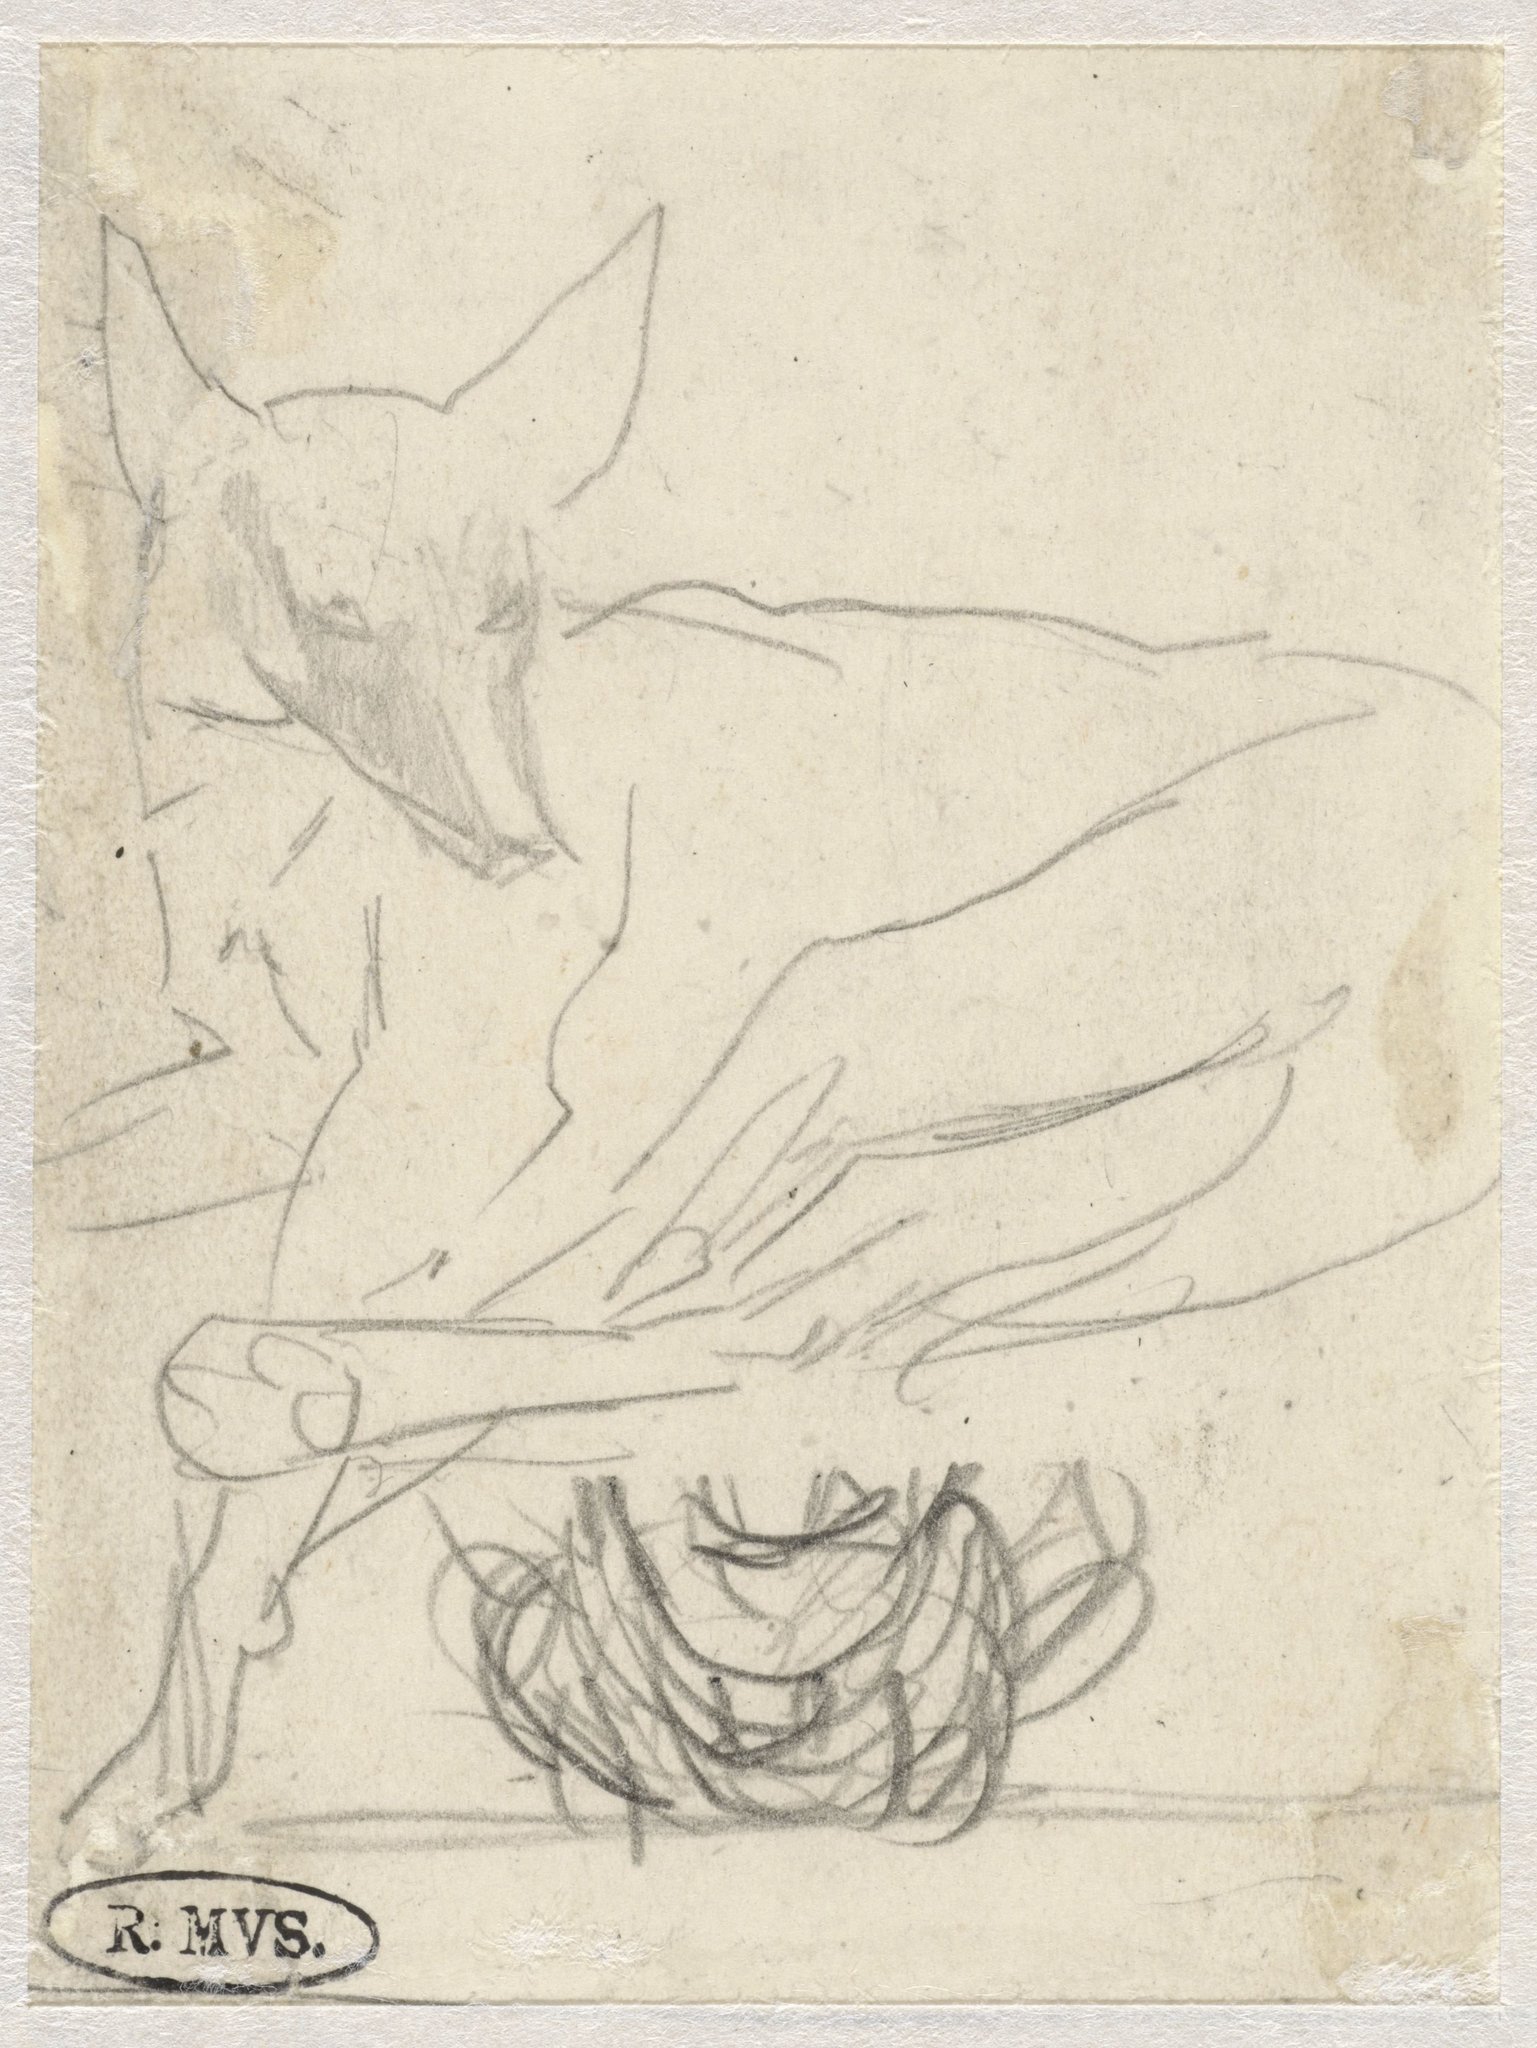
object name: drawing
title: Schets van een liggende vos of hond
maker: willem van konijnenburg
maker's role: draughtsman, painter, print maker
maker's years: 1868-1943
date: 1878-1943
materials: paper, pencil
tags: dog, beasts of prey, predatory animals: fox